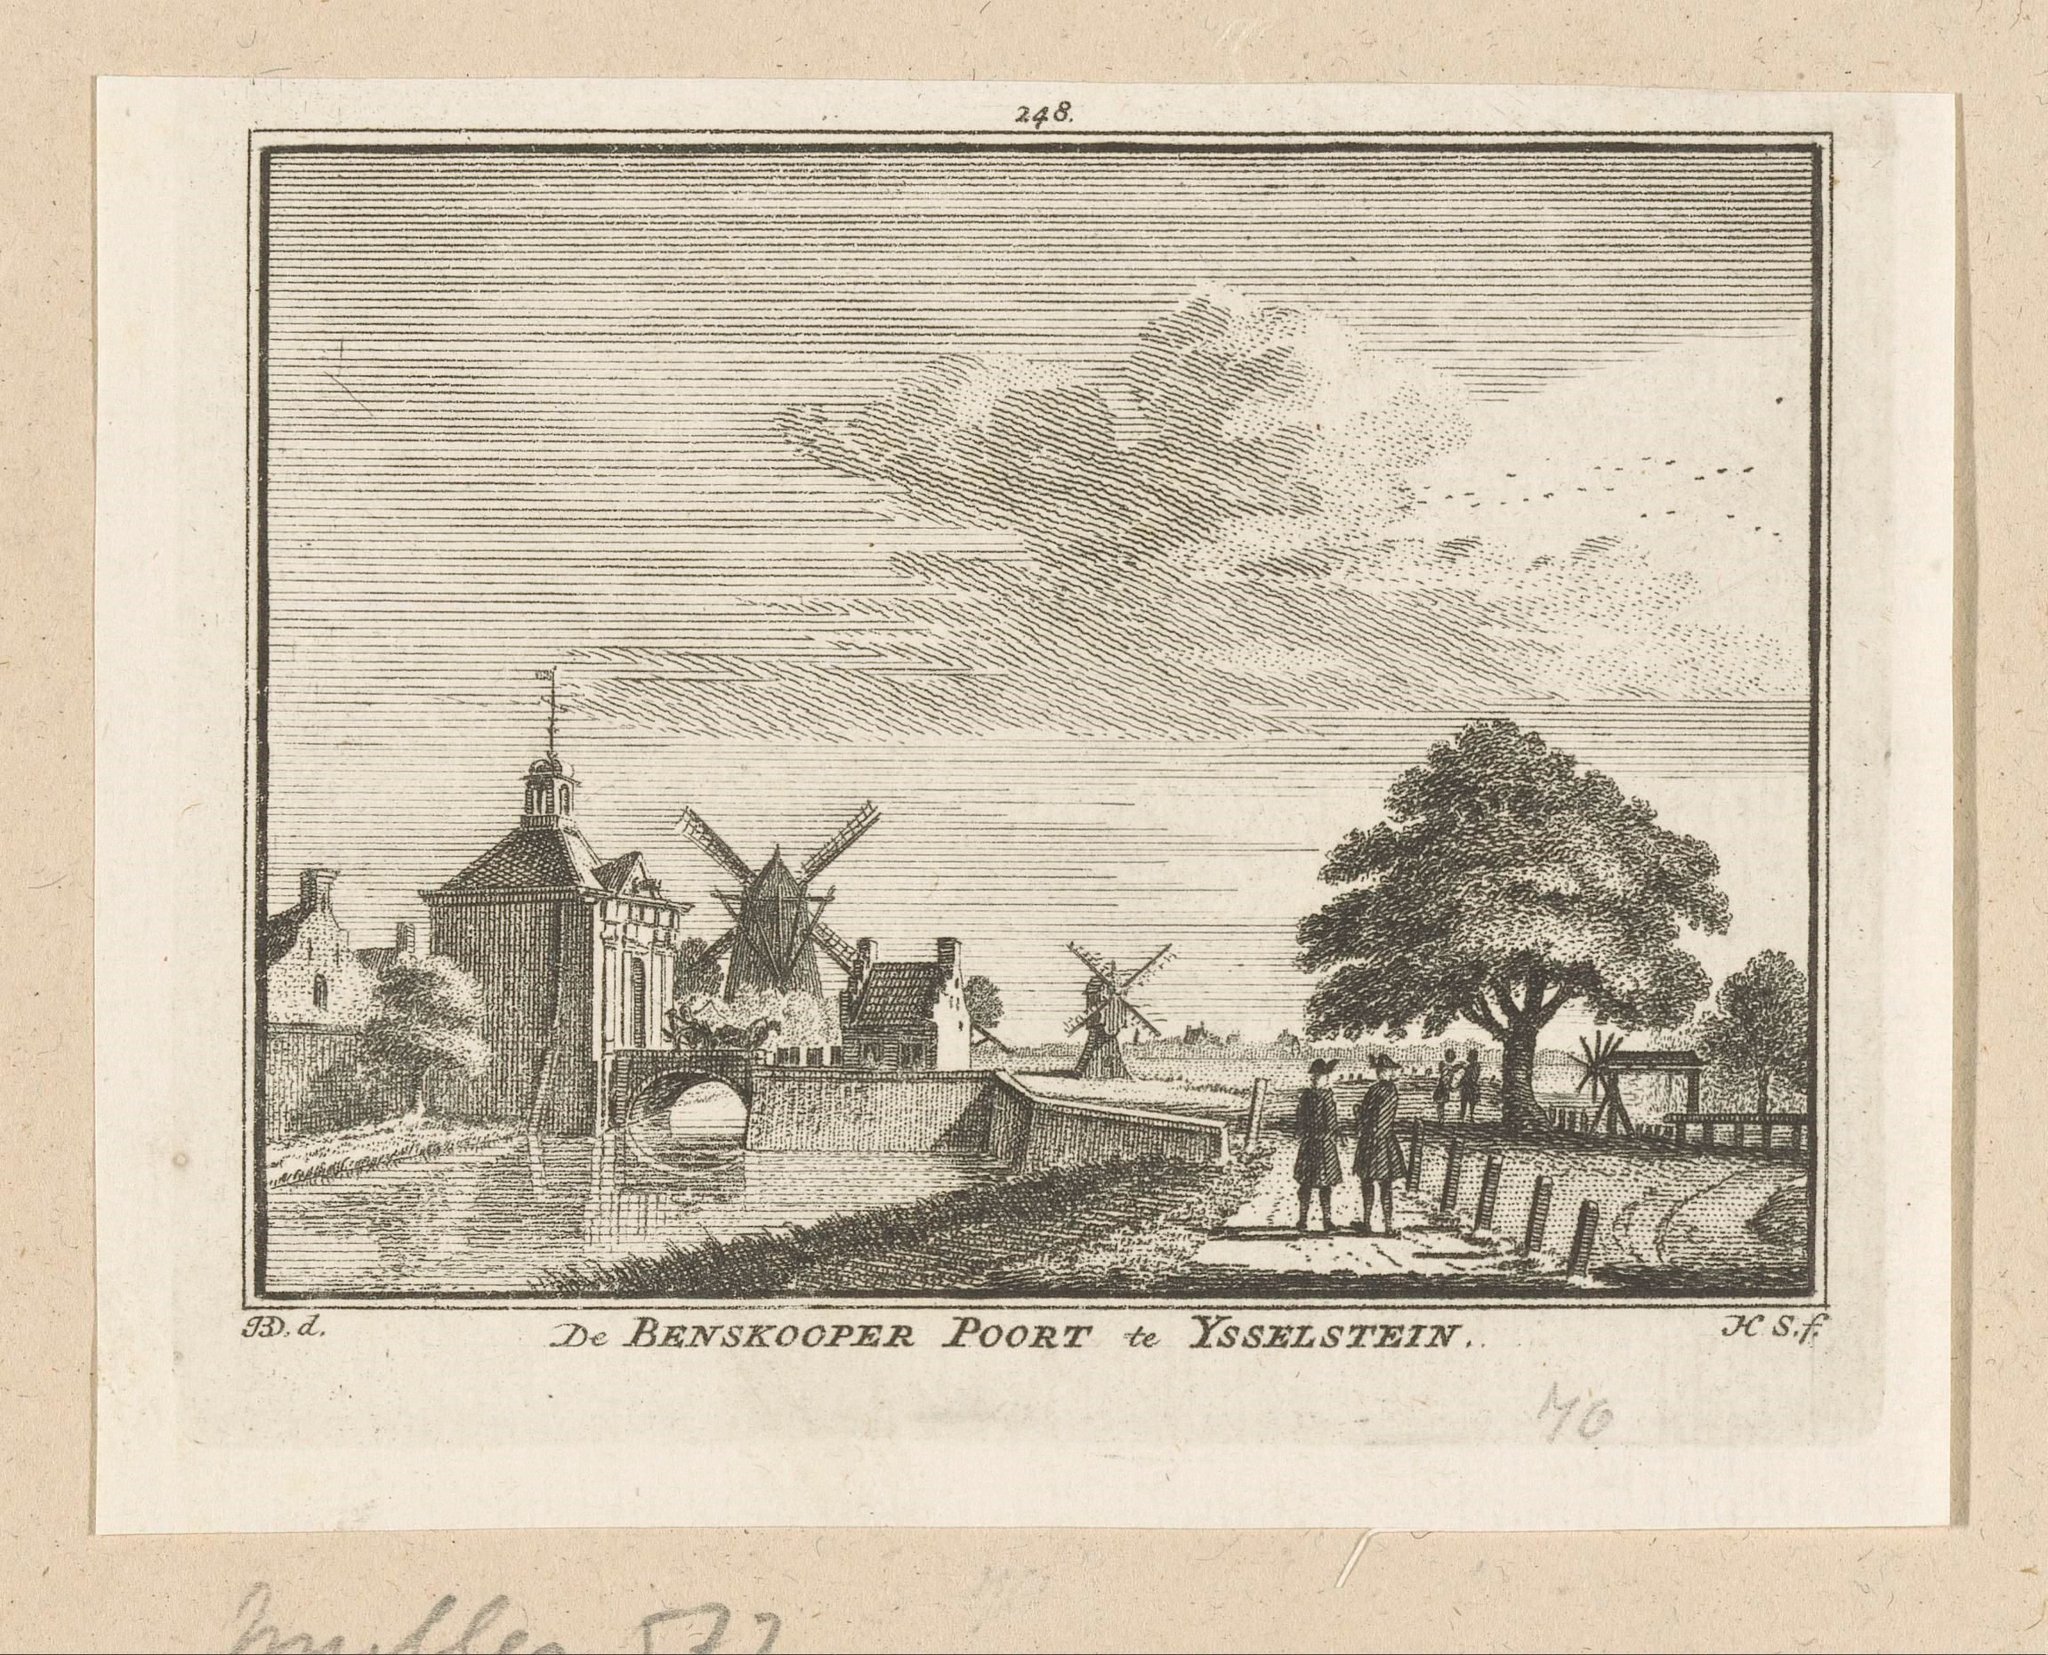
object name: book illustration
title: Gezicht op de Benschopperpoort te IJsselstein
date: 1750-1792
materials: paper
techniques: etching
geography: haarlem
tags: windmill, city-gate, village street (+ city(-scape) with figures, staffage), bridge in village across river, canal, etc. (+ city(-scape) with figures, staffage)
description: Prent ook gebruikt in: Het verheerlykt Nederland of kabinet van hedendaagsche gezigten van steden, dorpen (…). 9 delen. Amsterdam: Isaak Tirion en weduwe Isaak Tirion, 1745-1774, dl. 3 (1750), ill. 248. Of in: Nederlandsche tafereelen; of eene keurige verzameling van negen honderd fraaije gezigten van steden, dorpen, sloten, oudheden (….). 9 delen. Amsterdam: Jan de Groot, 1792, dl. 3, ill. 248.